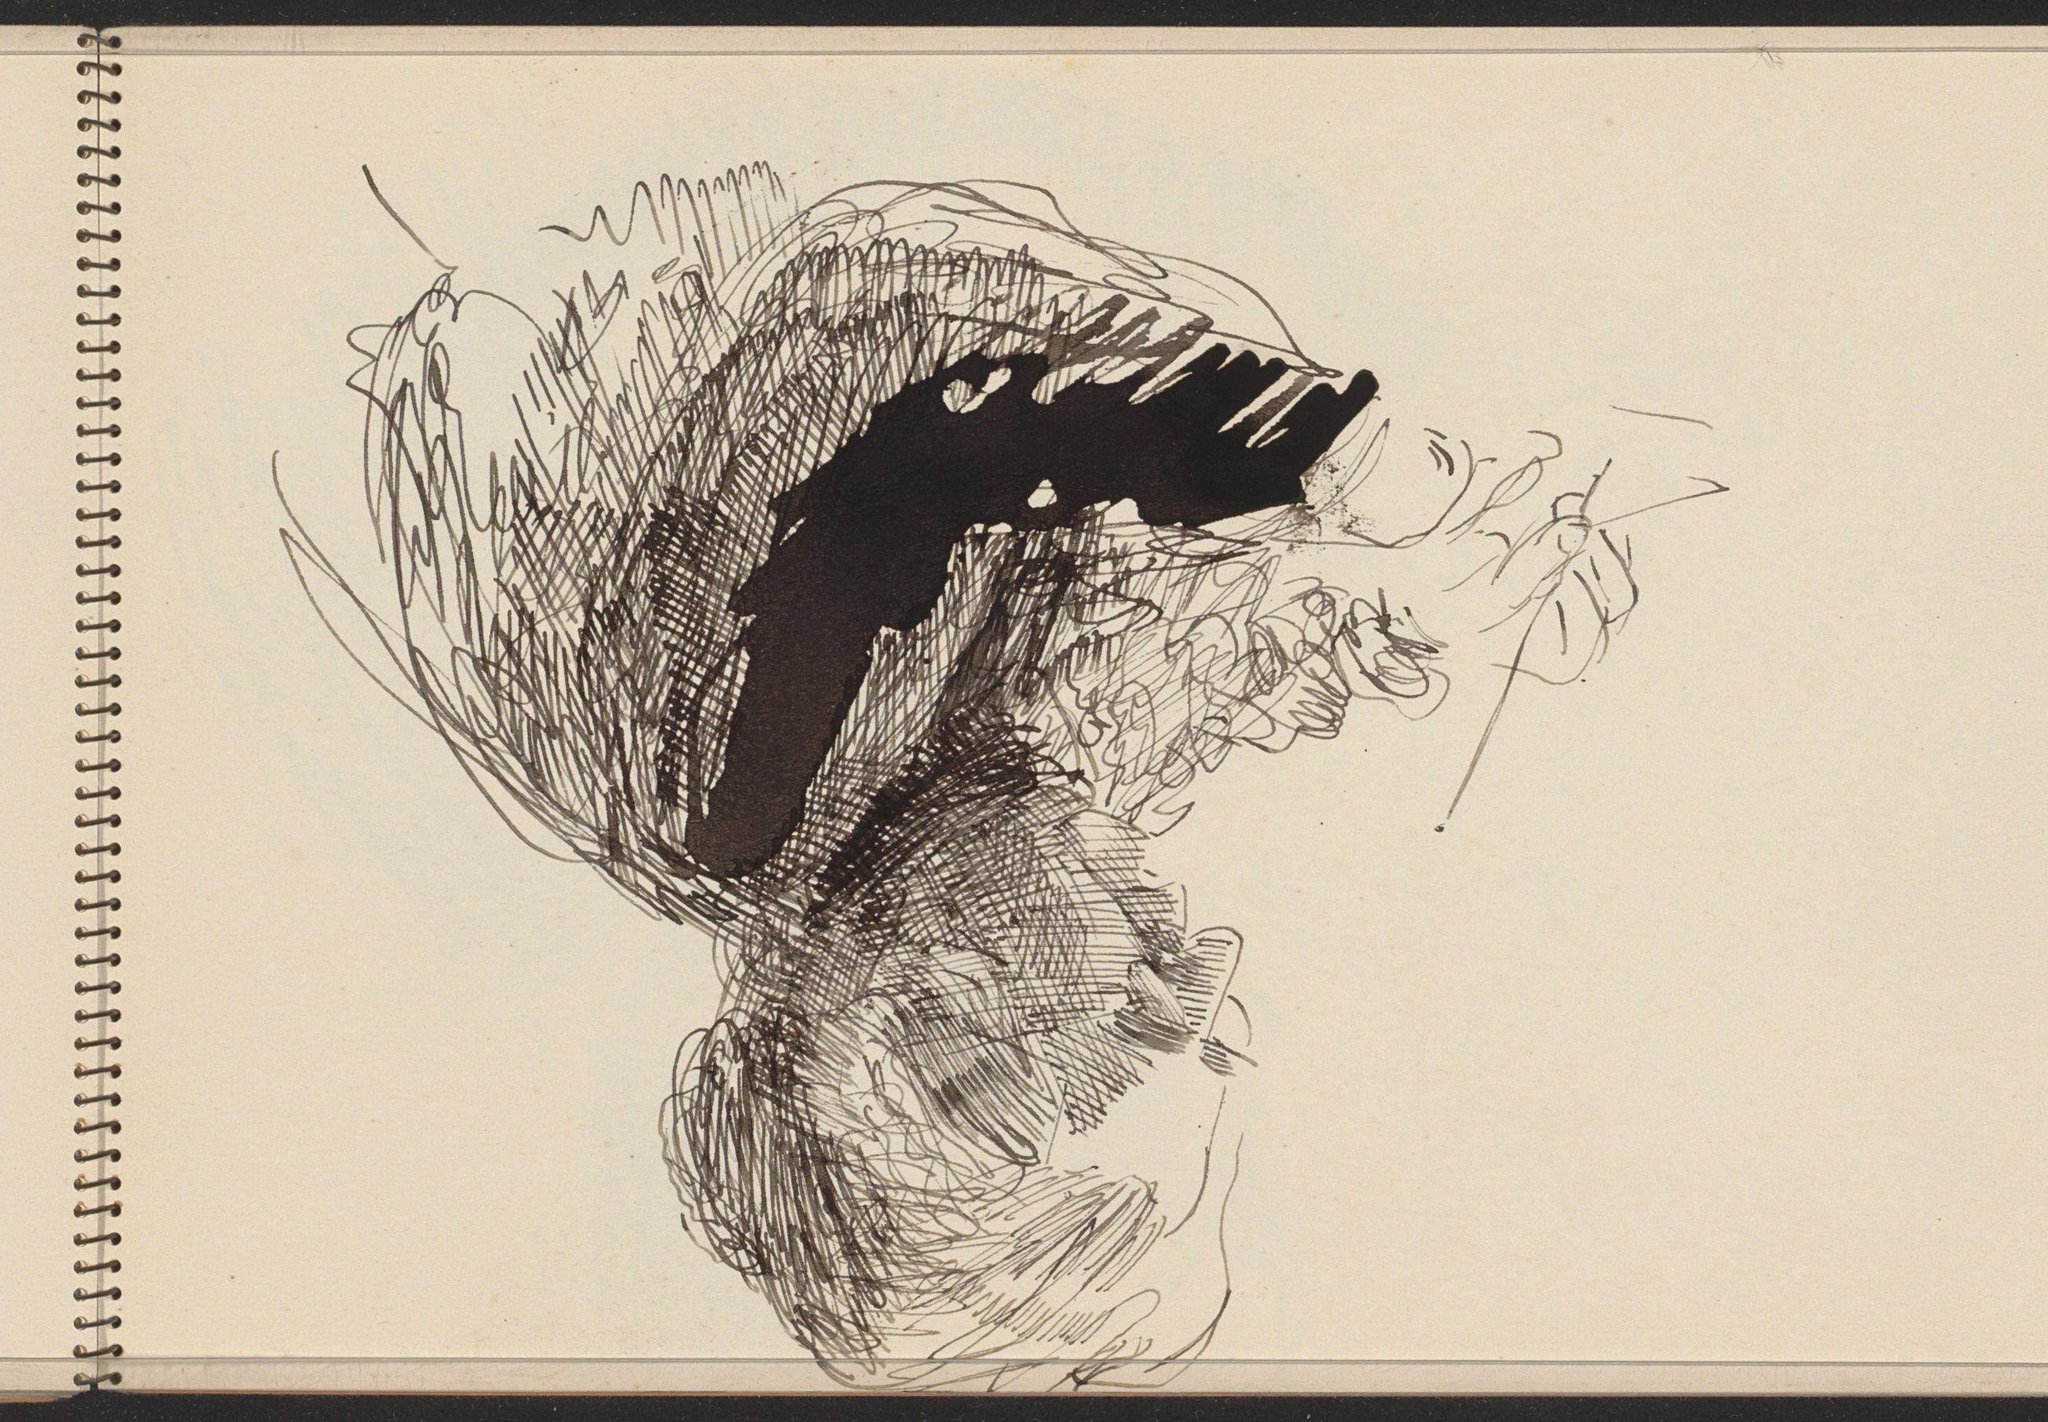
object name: sketchbook leaf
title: Schrijvende Joanna Lion Cachet-Cordes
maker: carel adolph lion cachet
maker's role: draughtsman, print maker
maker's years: 1864-1945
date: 1935-1940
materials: ink, paper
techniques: pen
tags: handwriting, writing as activity, adult woman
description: Blad 20 recto uit een schetsboek met 25 bladen.